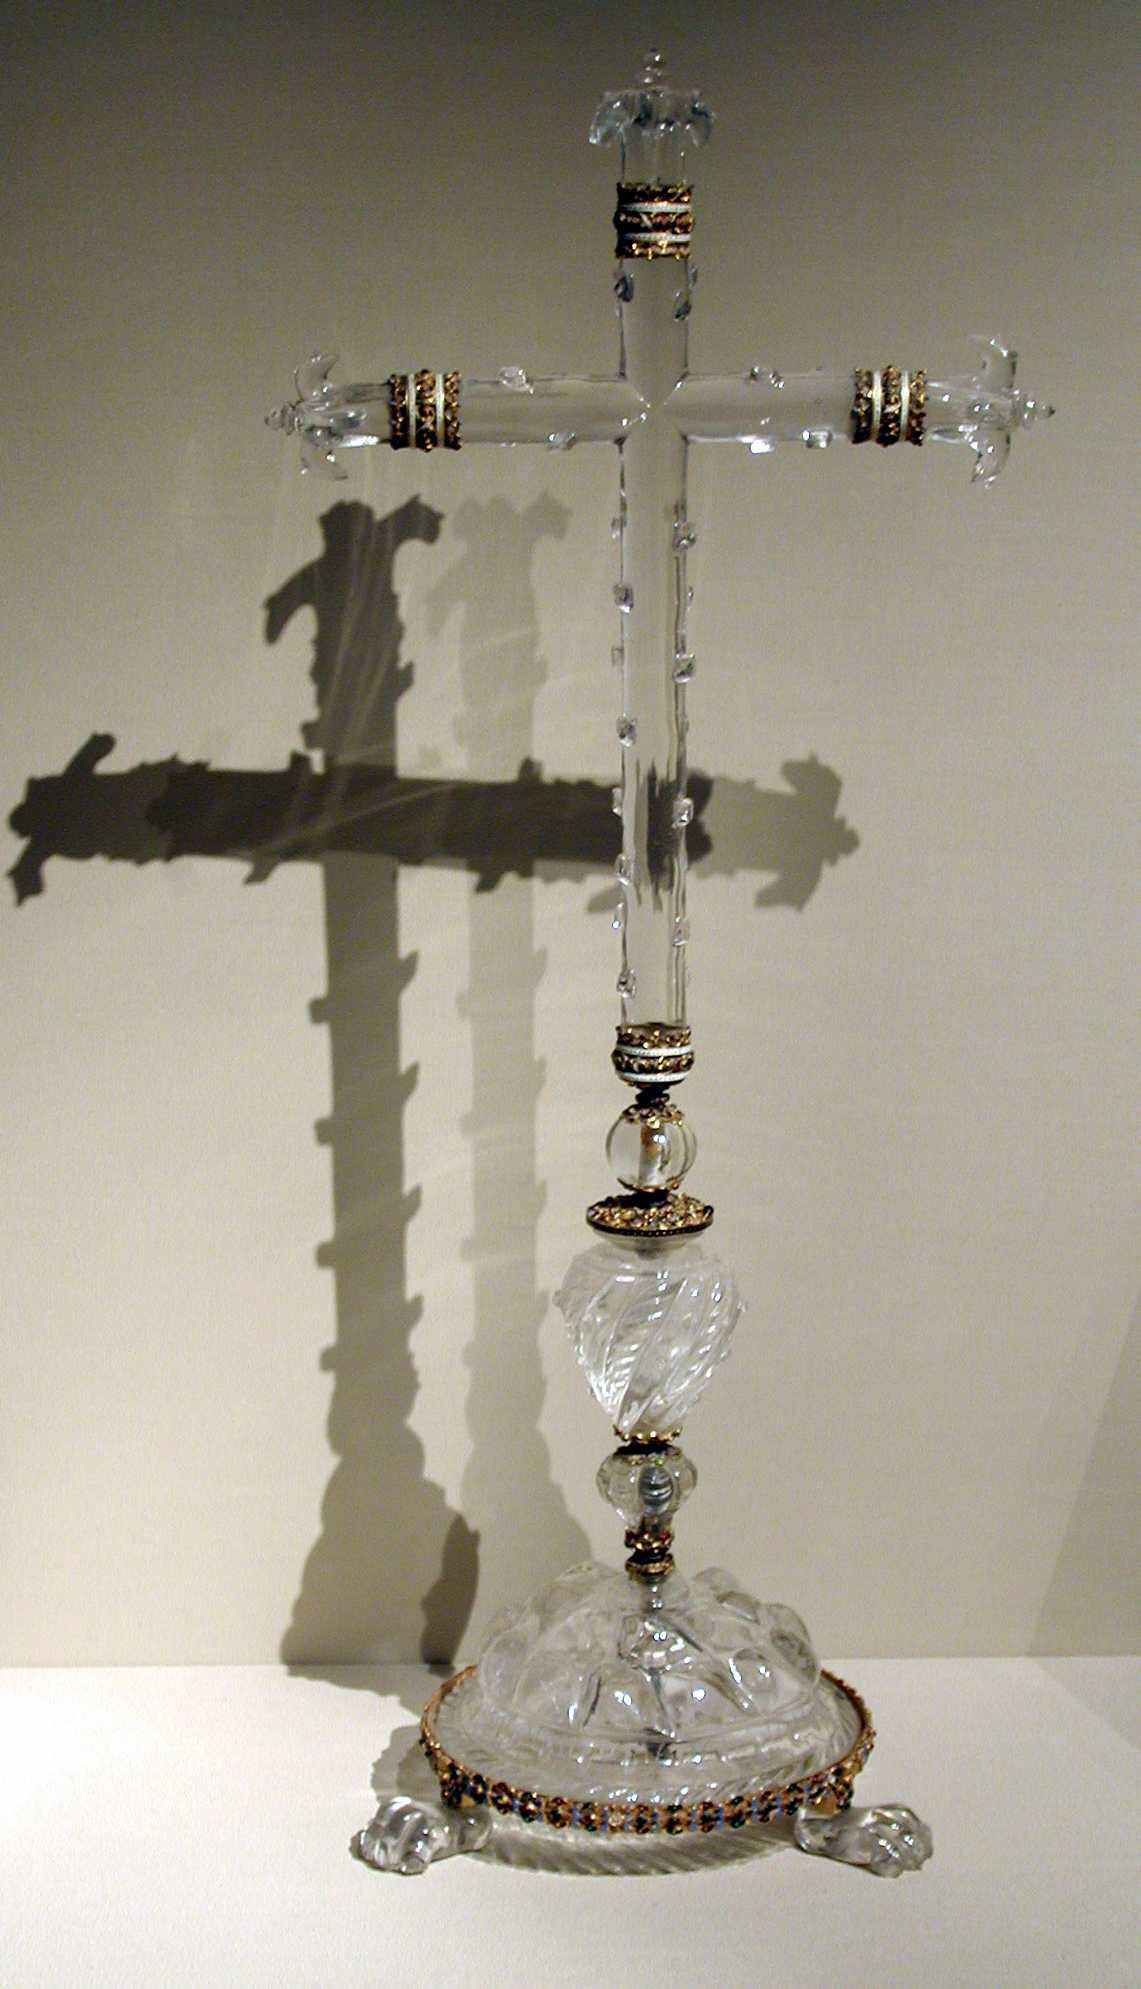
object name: altar cross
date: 1601-1700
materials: enamel, gold, quartz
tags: cross